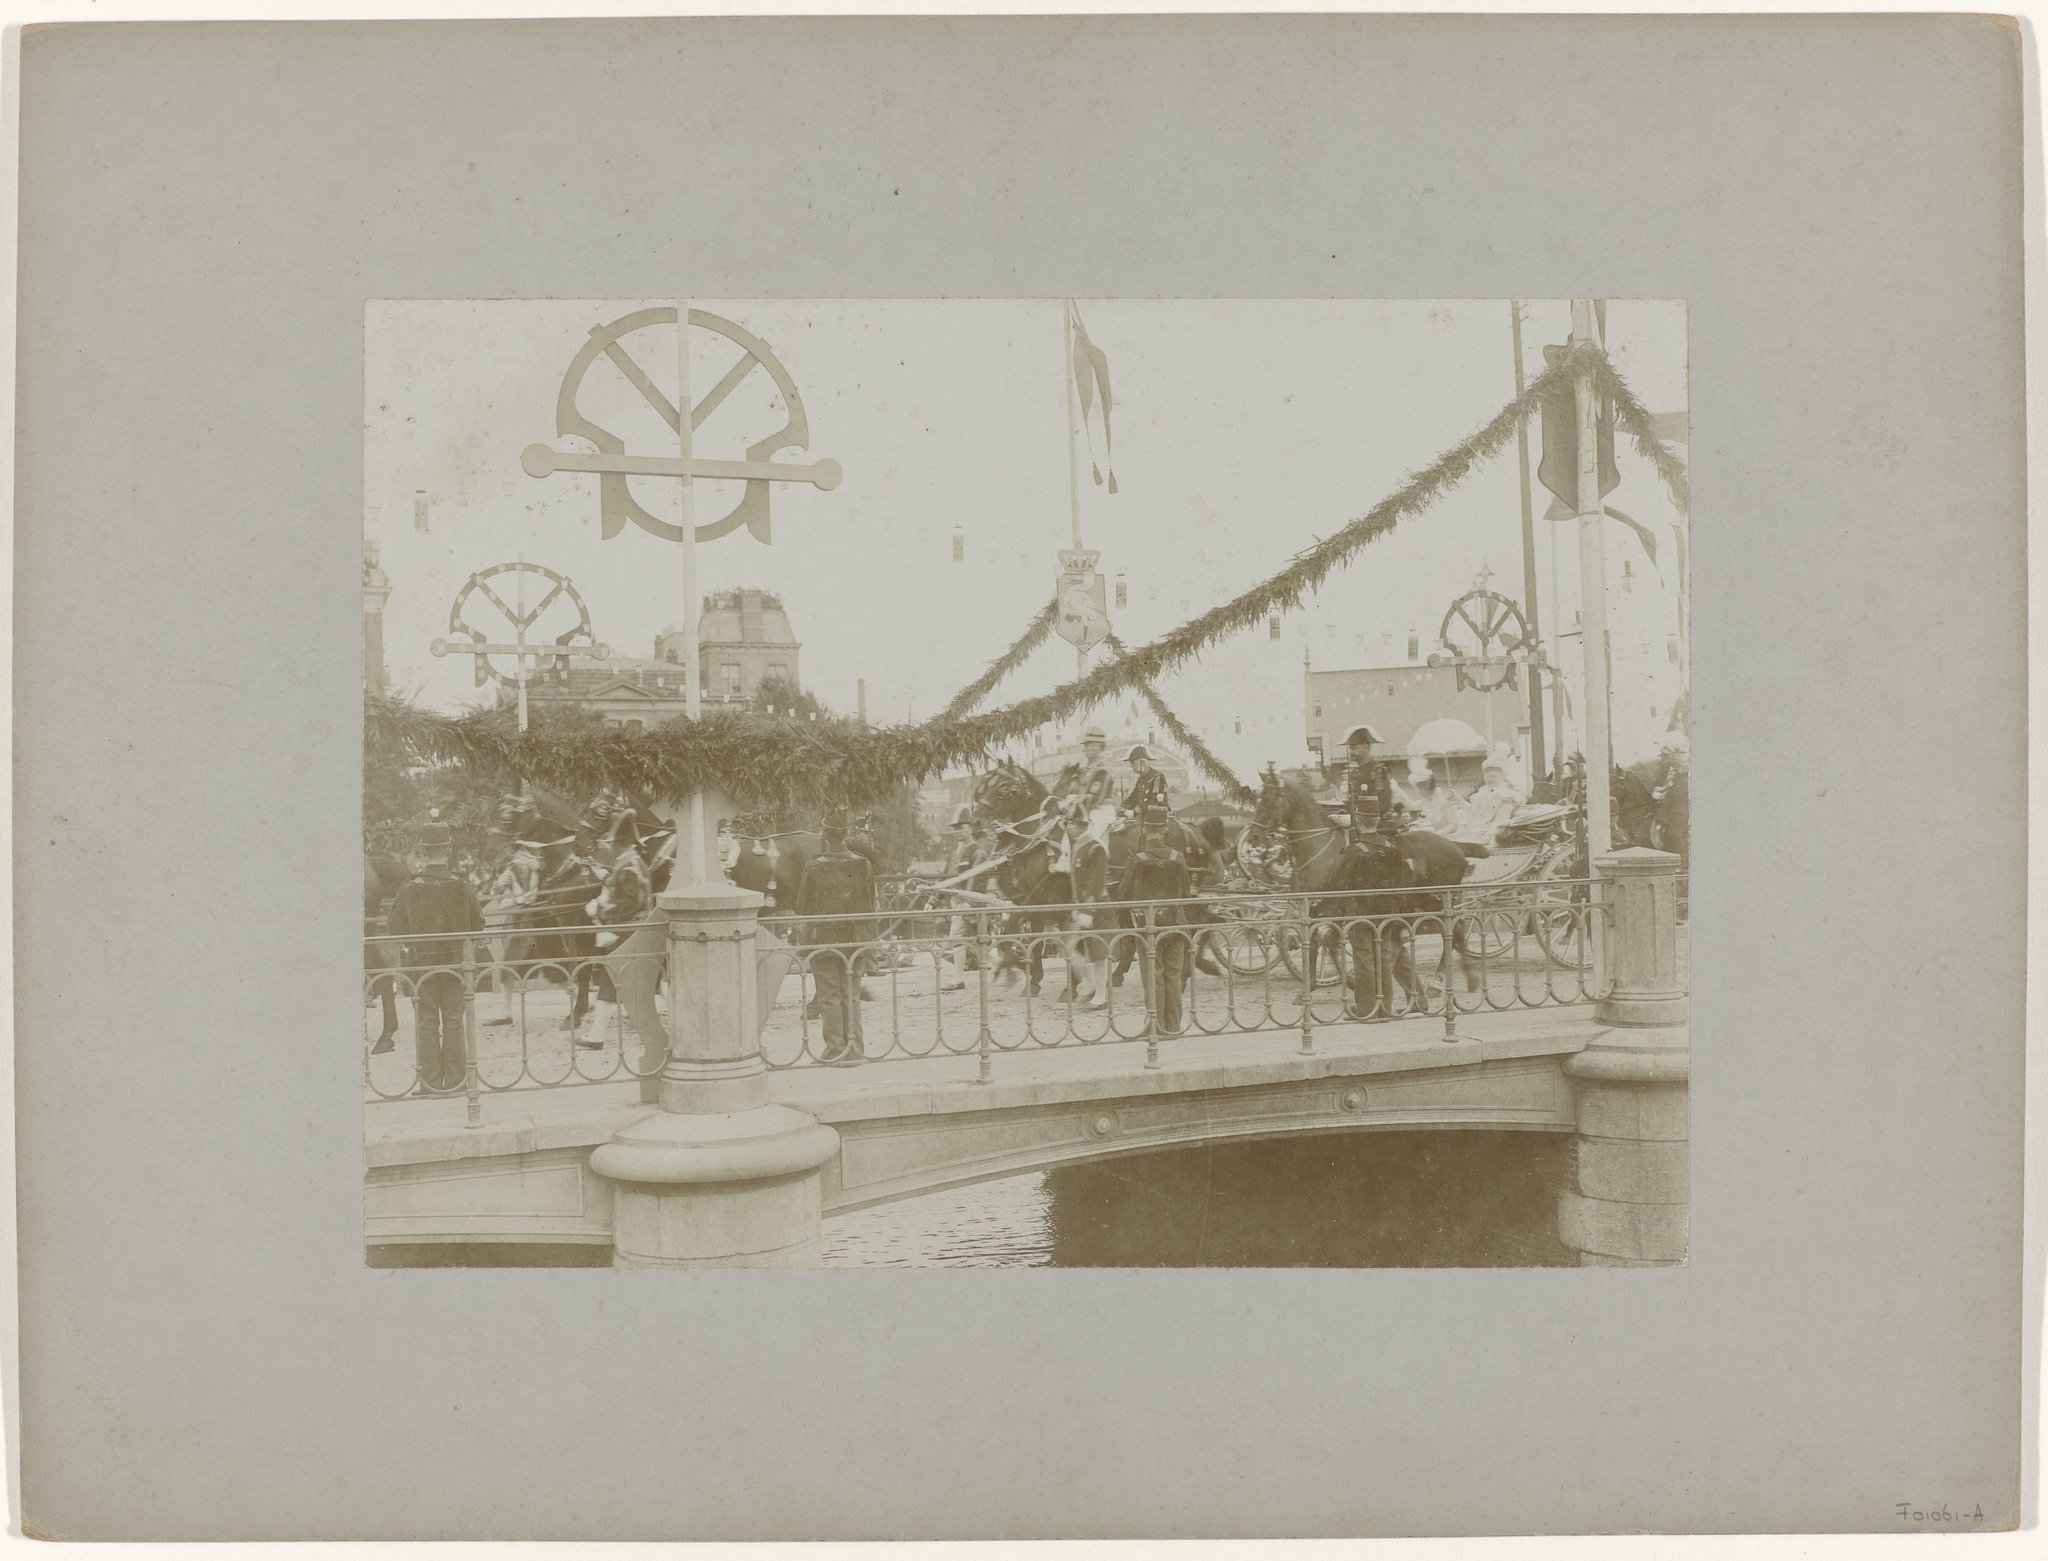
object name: photograph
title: Open rijtuig met koningin Wilhelmina en koningin-moeder Emma en escorte bij de inhuldiging in Amsterdam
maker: barend groote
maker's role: fotograaf, fotohandel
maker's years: 1862-1946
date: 1809-1898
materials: photographic support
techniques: collodion silver print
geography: amsterdam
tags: the hague, print maker, wilhelmina of the netherlands, emma (queen consort of the netherlands), riding a horse, ass, or mule; rider, horseman, ceremonial celebration of installation of a ruler, public festivities on the occasion of royal events, installation of a ruler - bb - female ruler, four-wheeled, animal-drawn vehicle, e.g.: cab, carriage, coach, amsterdam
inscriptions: name: ‘B. Groote & Co. Kalverstraat 43 Amsterdam’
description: Onderdeel van Fotoalbum met tien opnames van de inhuldiging van koningin Wilhelmina en de inhuldigingsfeesten.